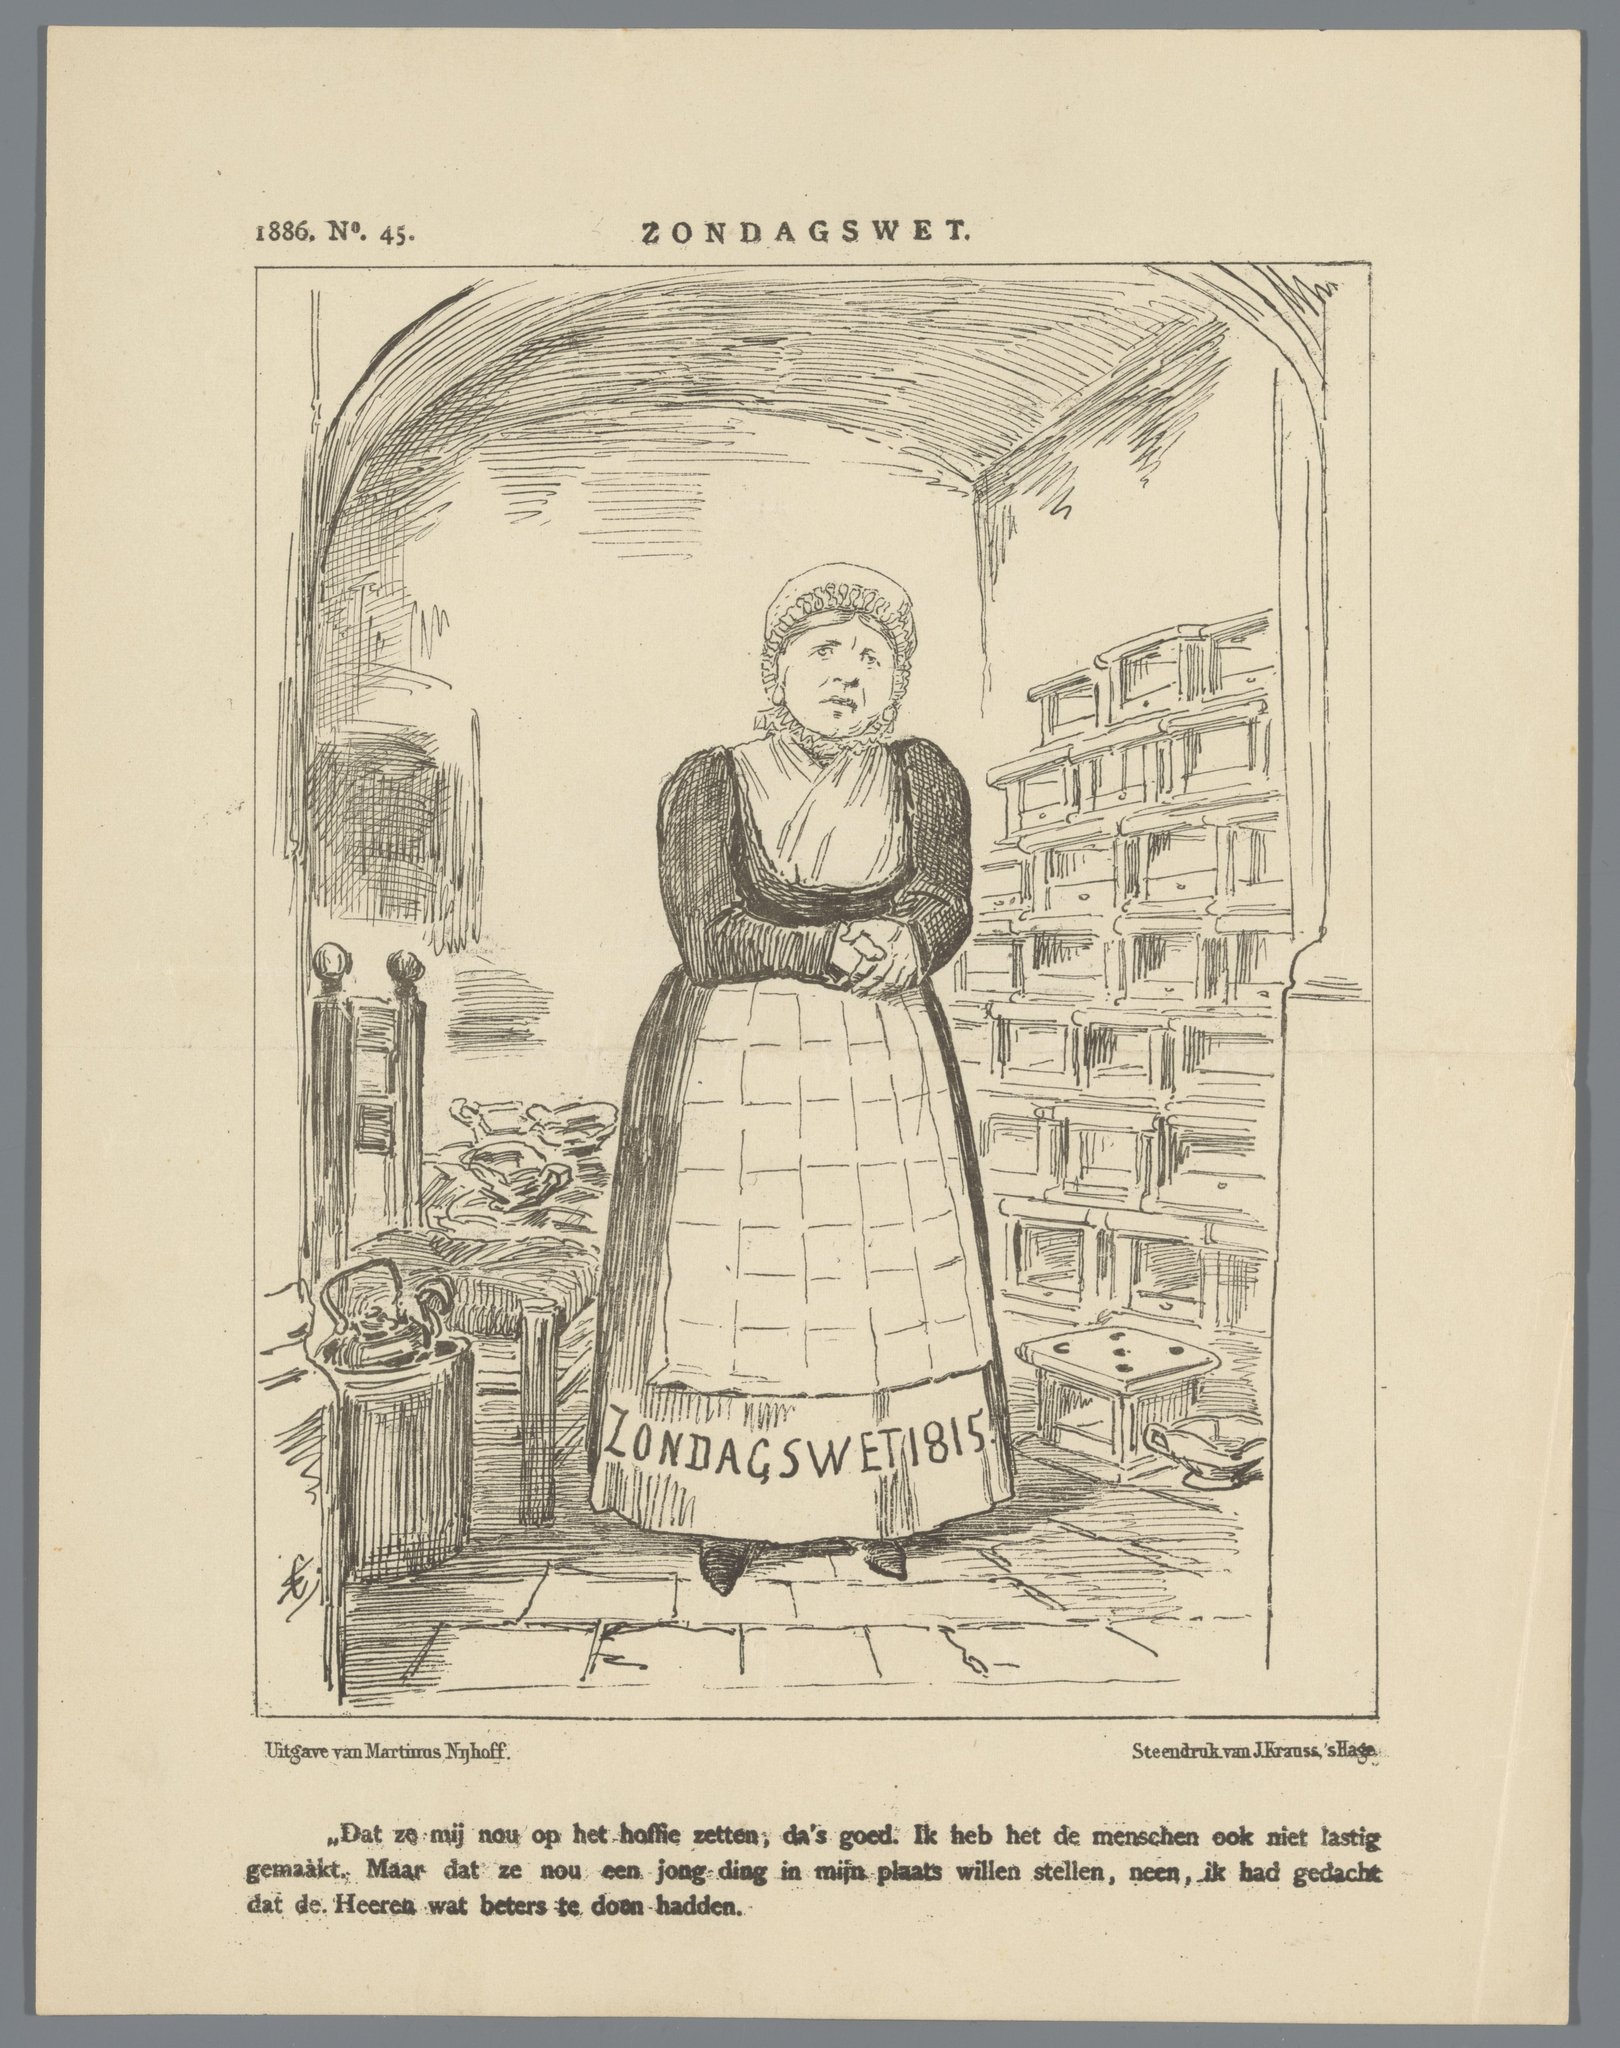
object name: cartoon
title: Spotprent op de Zondagswet, 1886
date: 1886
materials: paper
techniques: lithograph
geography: the hague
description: Spotprent op de Zondagswet van 1815. Plaat verschenen bij het weekblad De Nederlandsche Spectator, nr. 45, 1886.